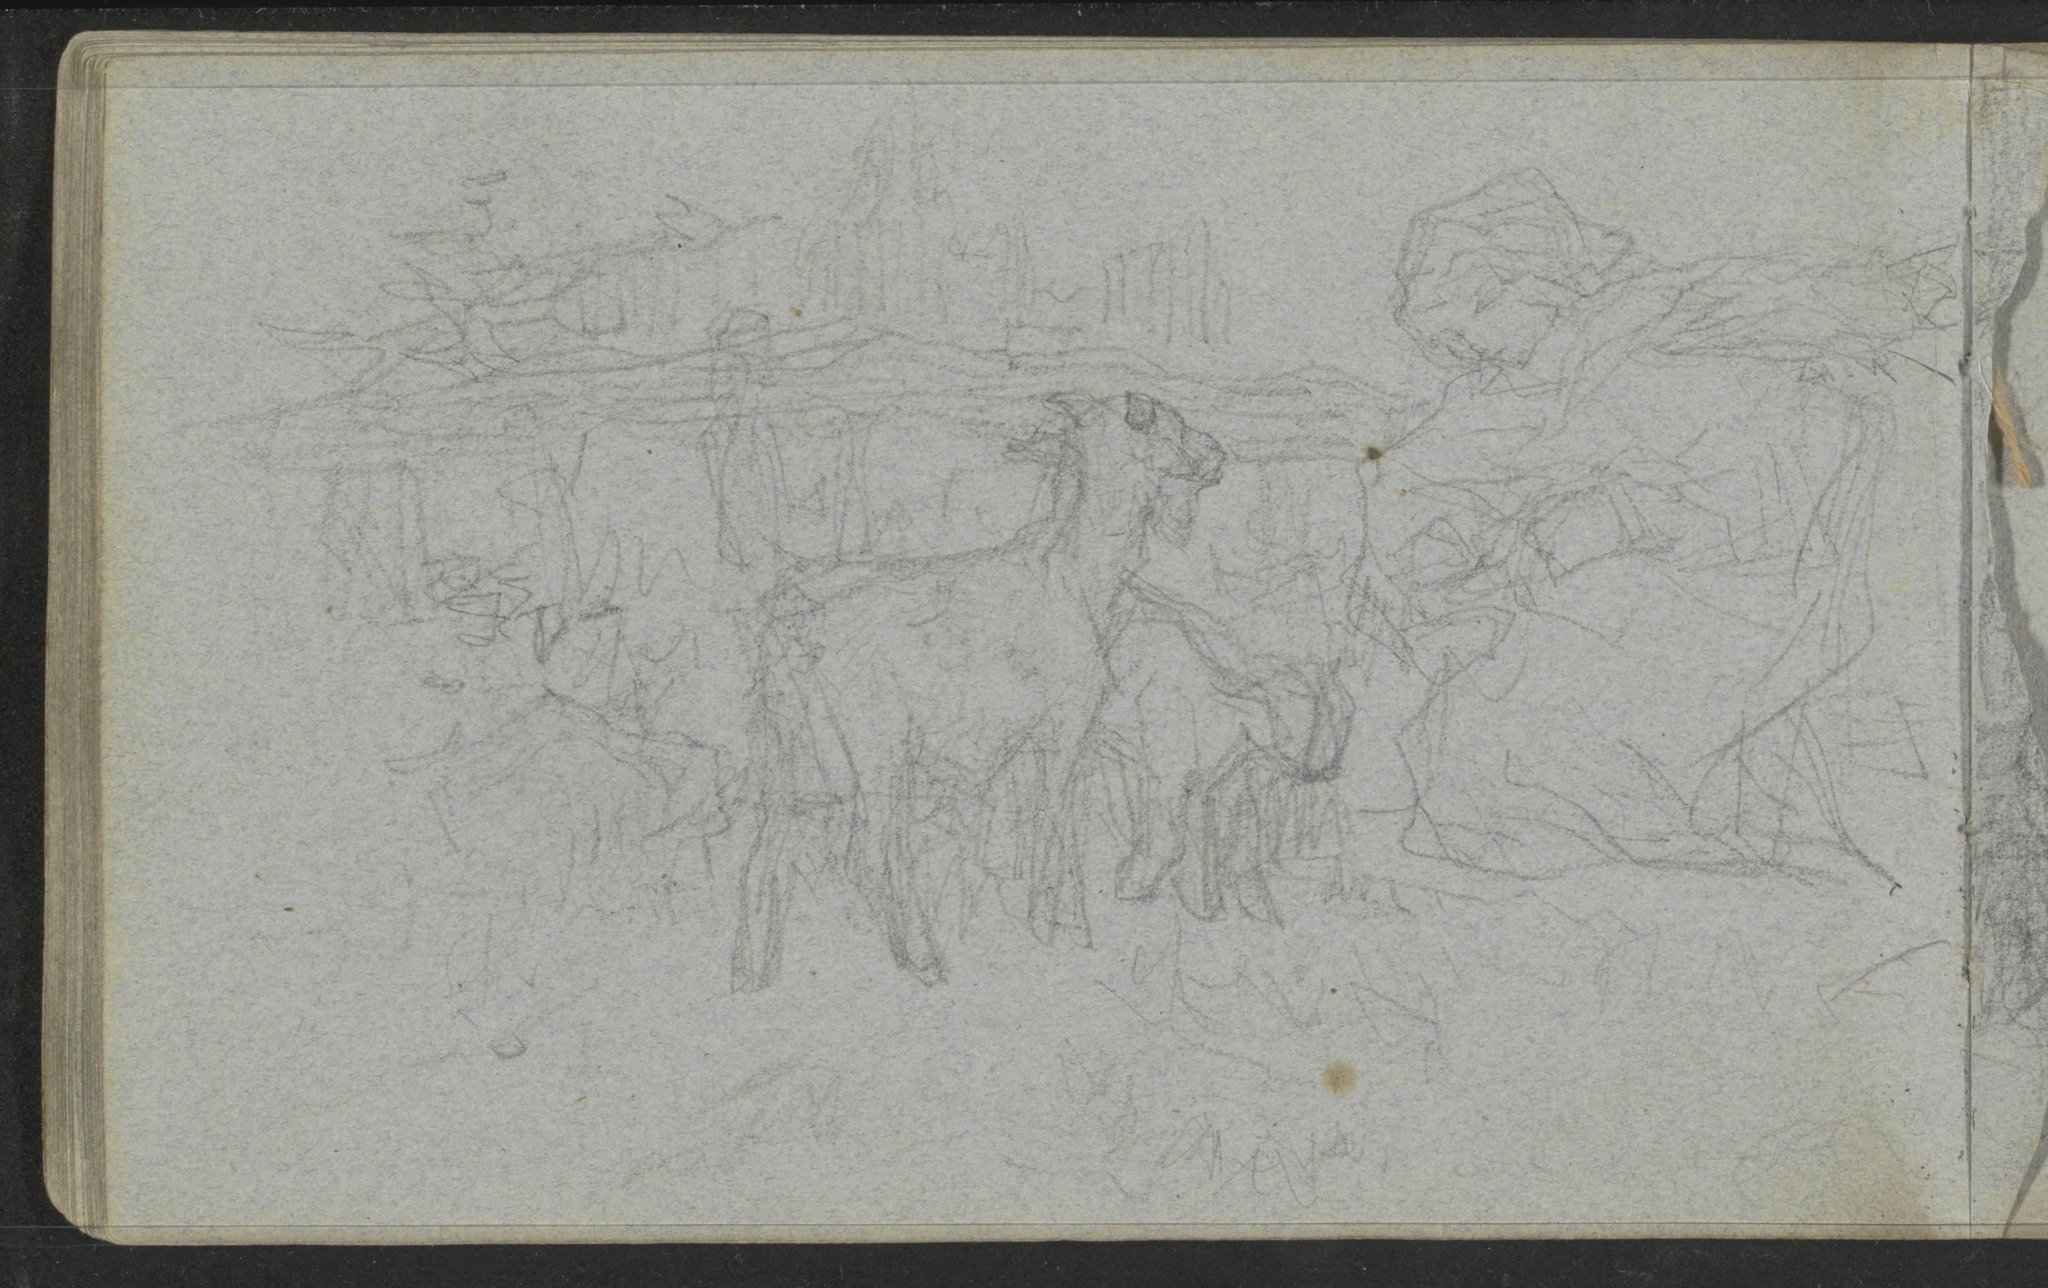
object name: sketchbook leaf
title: Landschap met een vrouw knielend bij enkele geiten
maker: matthijs maris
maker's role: draughtsman, painter, print maker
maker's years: 1839-1917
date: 1849-1917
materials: paper, pencil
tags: kneeling figure (+ female (human being) (not to be used where -aa- is prescribed)), goat, landscapes (+ landscape with figures, staffage)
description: Blad 18 verso uit een schetsboek met 35 bladen.